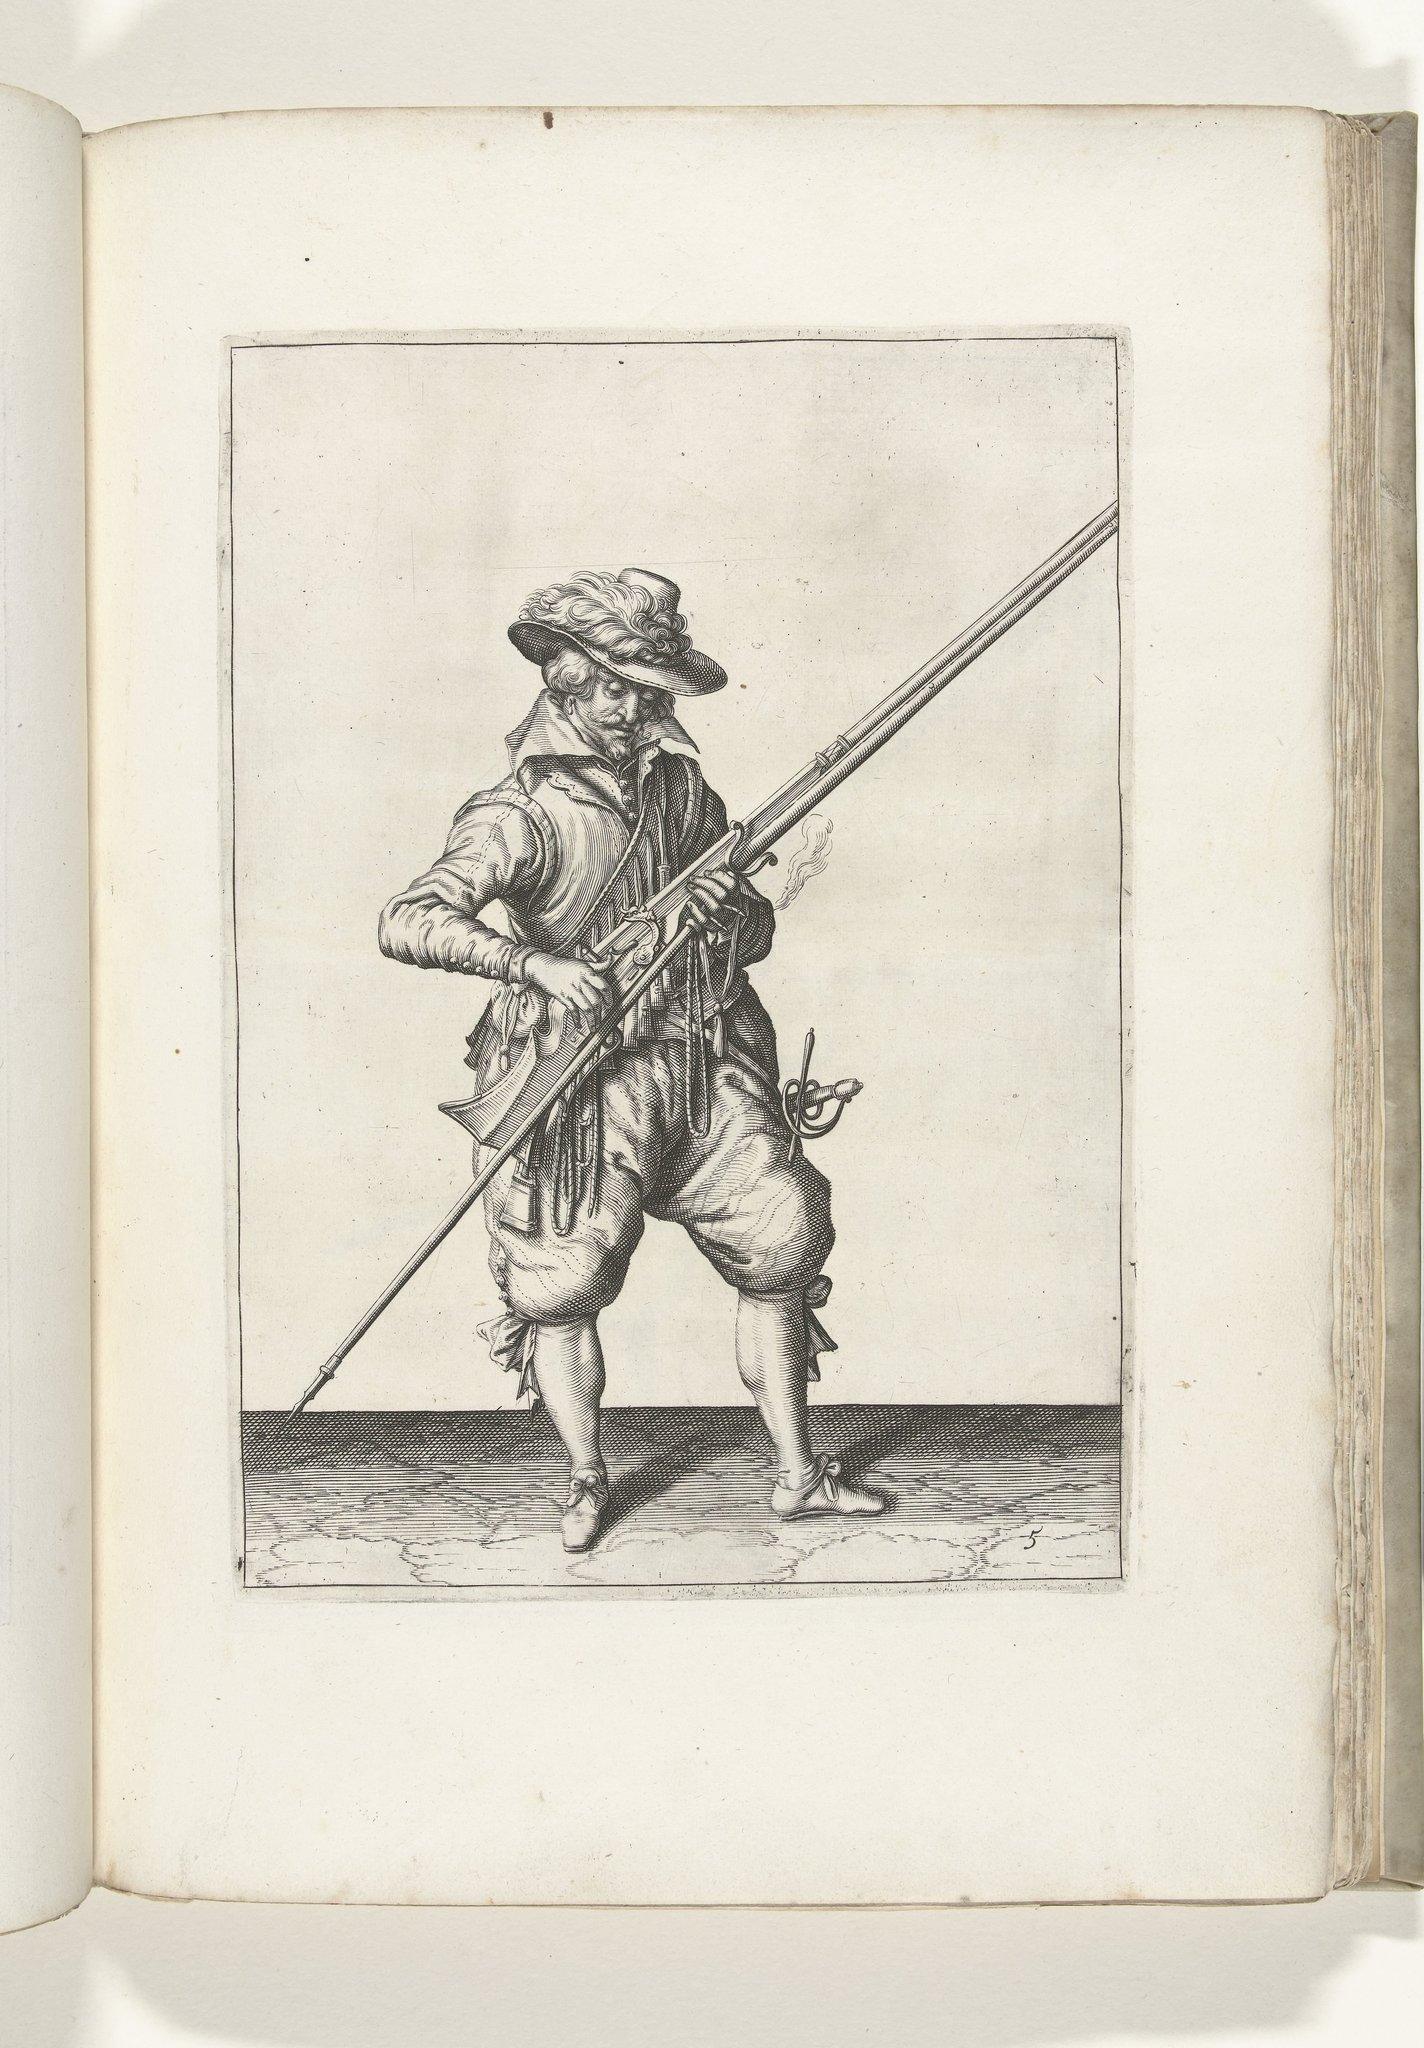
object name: print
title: Soldaat die zijn musket met zijn linkerhand bij zijn rechterzijde vasthoudt (nr. 5), ca. 1600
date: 1597-1607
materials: paper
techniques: engraving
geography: northern netherlands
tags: the hague, maurice (prince of orange), handling of weapons ~ military training, weapons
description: Een soldaat, ten voeten uit, naar rechts, die een musket (een bepaald type vuurwapen) met zijn linkerhand bij zijn rechterzijde vasthoudt (nr. 5), ca. 1600. In zijn linkerhand behalve het musket ook een furket (musketvork) en een brandende lont. Zijn rechterhand losjes bij de trekker van het musket. Plaat 5 in de instructies voor het hanteren van het musket: Corte onderrechtinghe op de figuerliicke afbeeldinghe, soo veel aengaet het recht ghebruyck vant Musquet. Onderdeel van de illustraties in: J. de Gheyn, Wapenhandelinghe van Roers Musquetten ende spiessen, 's-Gravenhage, 1607. Krijgswezen rond 1600.